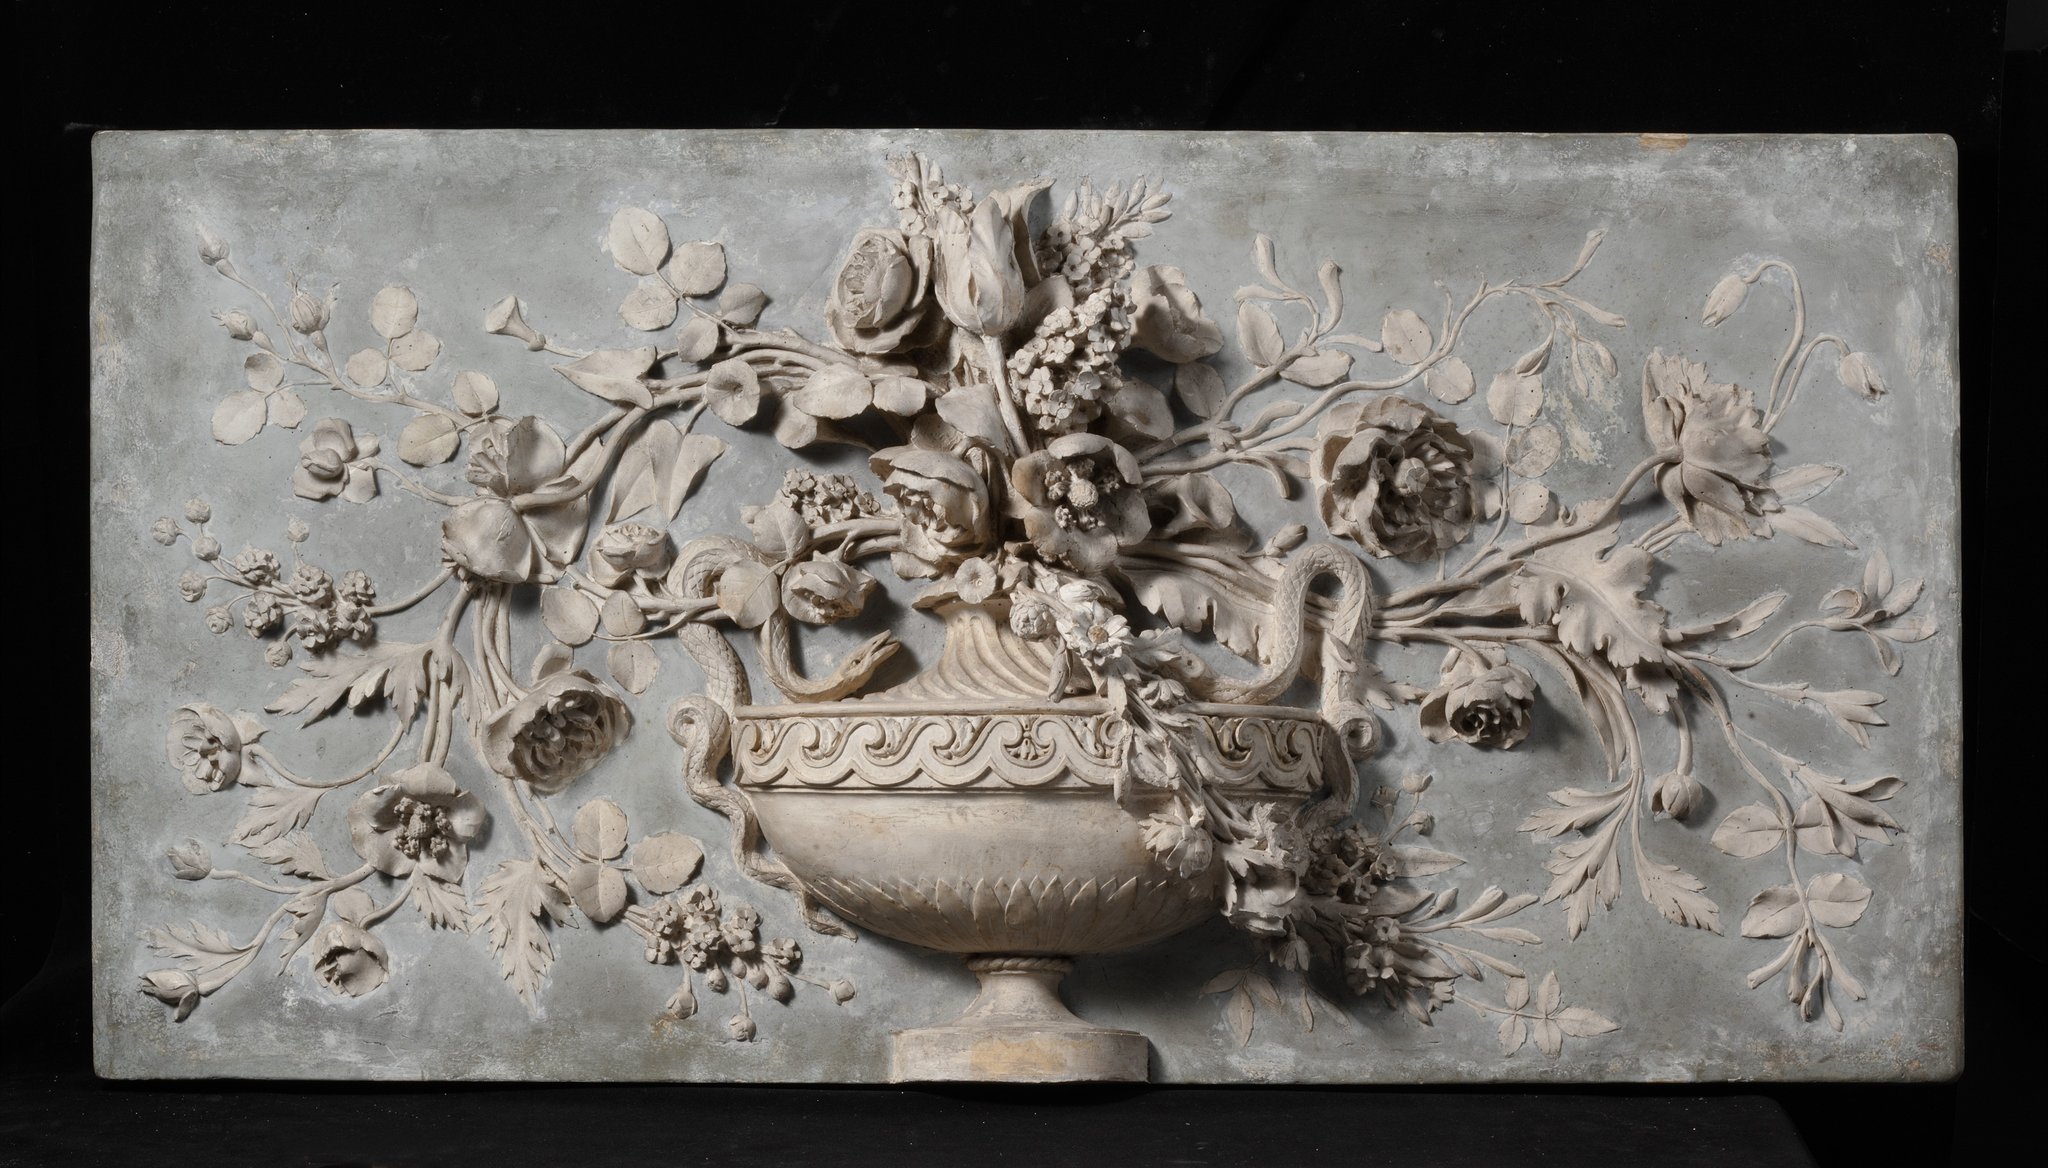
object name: overdoor panel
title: Pair of overdoor panels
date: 1783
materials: plaster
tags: flowers,leaves